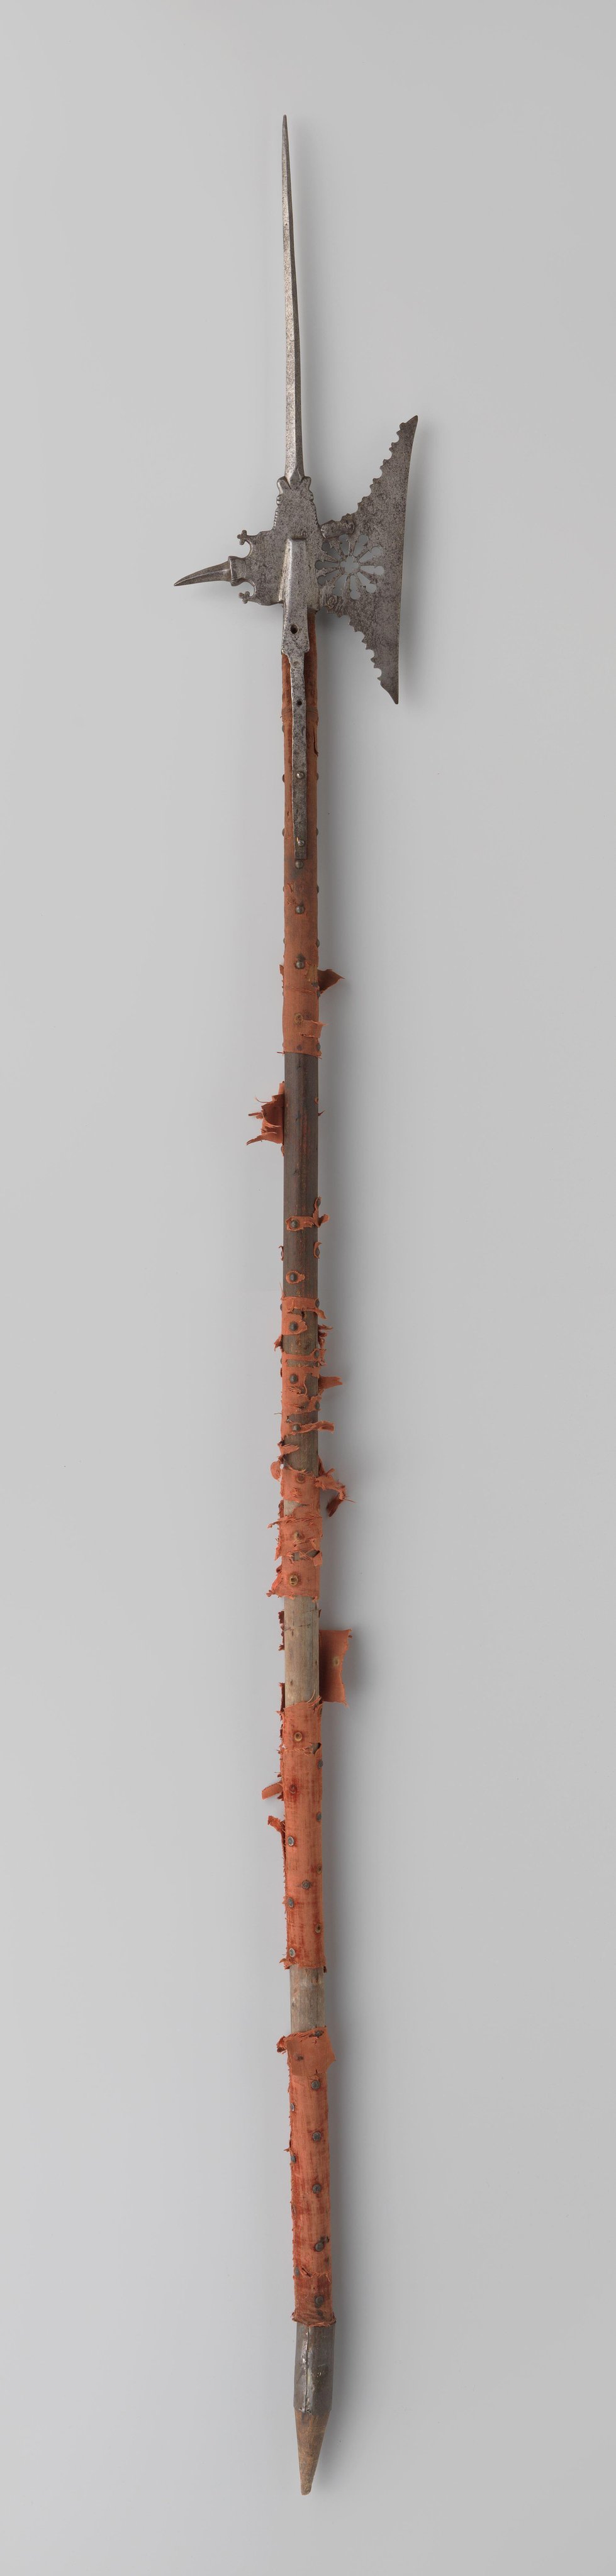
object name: halberd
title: Hellebaard met haak versierd met twee klaverblaadjes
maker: Anonymous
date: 1500-1600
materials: iron, velvet, wood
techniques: forging, riveted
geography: western europe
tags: west-europa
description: Hellebaard samengesteld uit een rozetvormig opengewerkte bijl met een rechte snede en paarsgewijs geschulpte boven- en onderzijde, een zeer decoratieve doornvormige punt aan een blad met geknikte boven- en onderzijde, waarbij de knik zelf is geaccentueerd met stervormige bekroning, en een zeer ranke, vierhoekige stootkling met rechte sneden. Deze vormen een geheel met het konische huis. De schachtveren zijn met afwisselend klinknagels en schroeven bevestigd aan de met rood fluweel beklede schacht. De schacht is voorzien van een schoen.